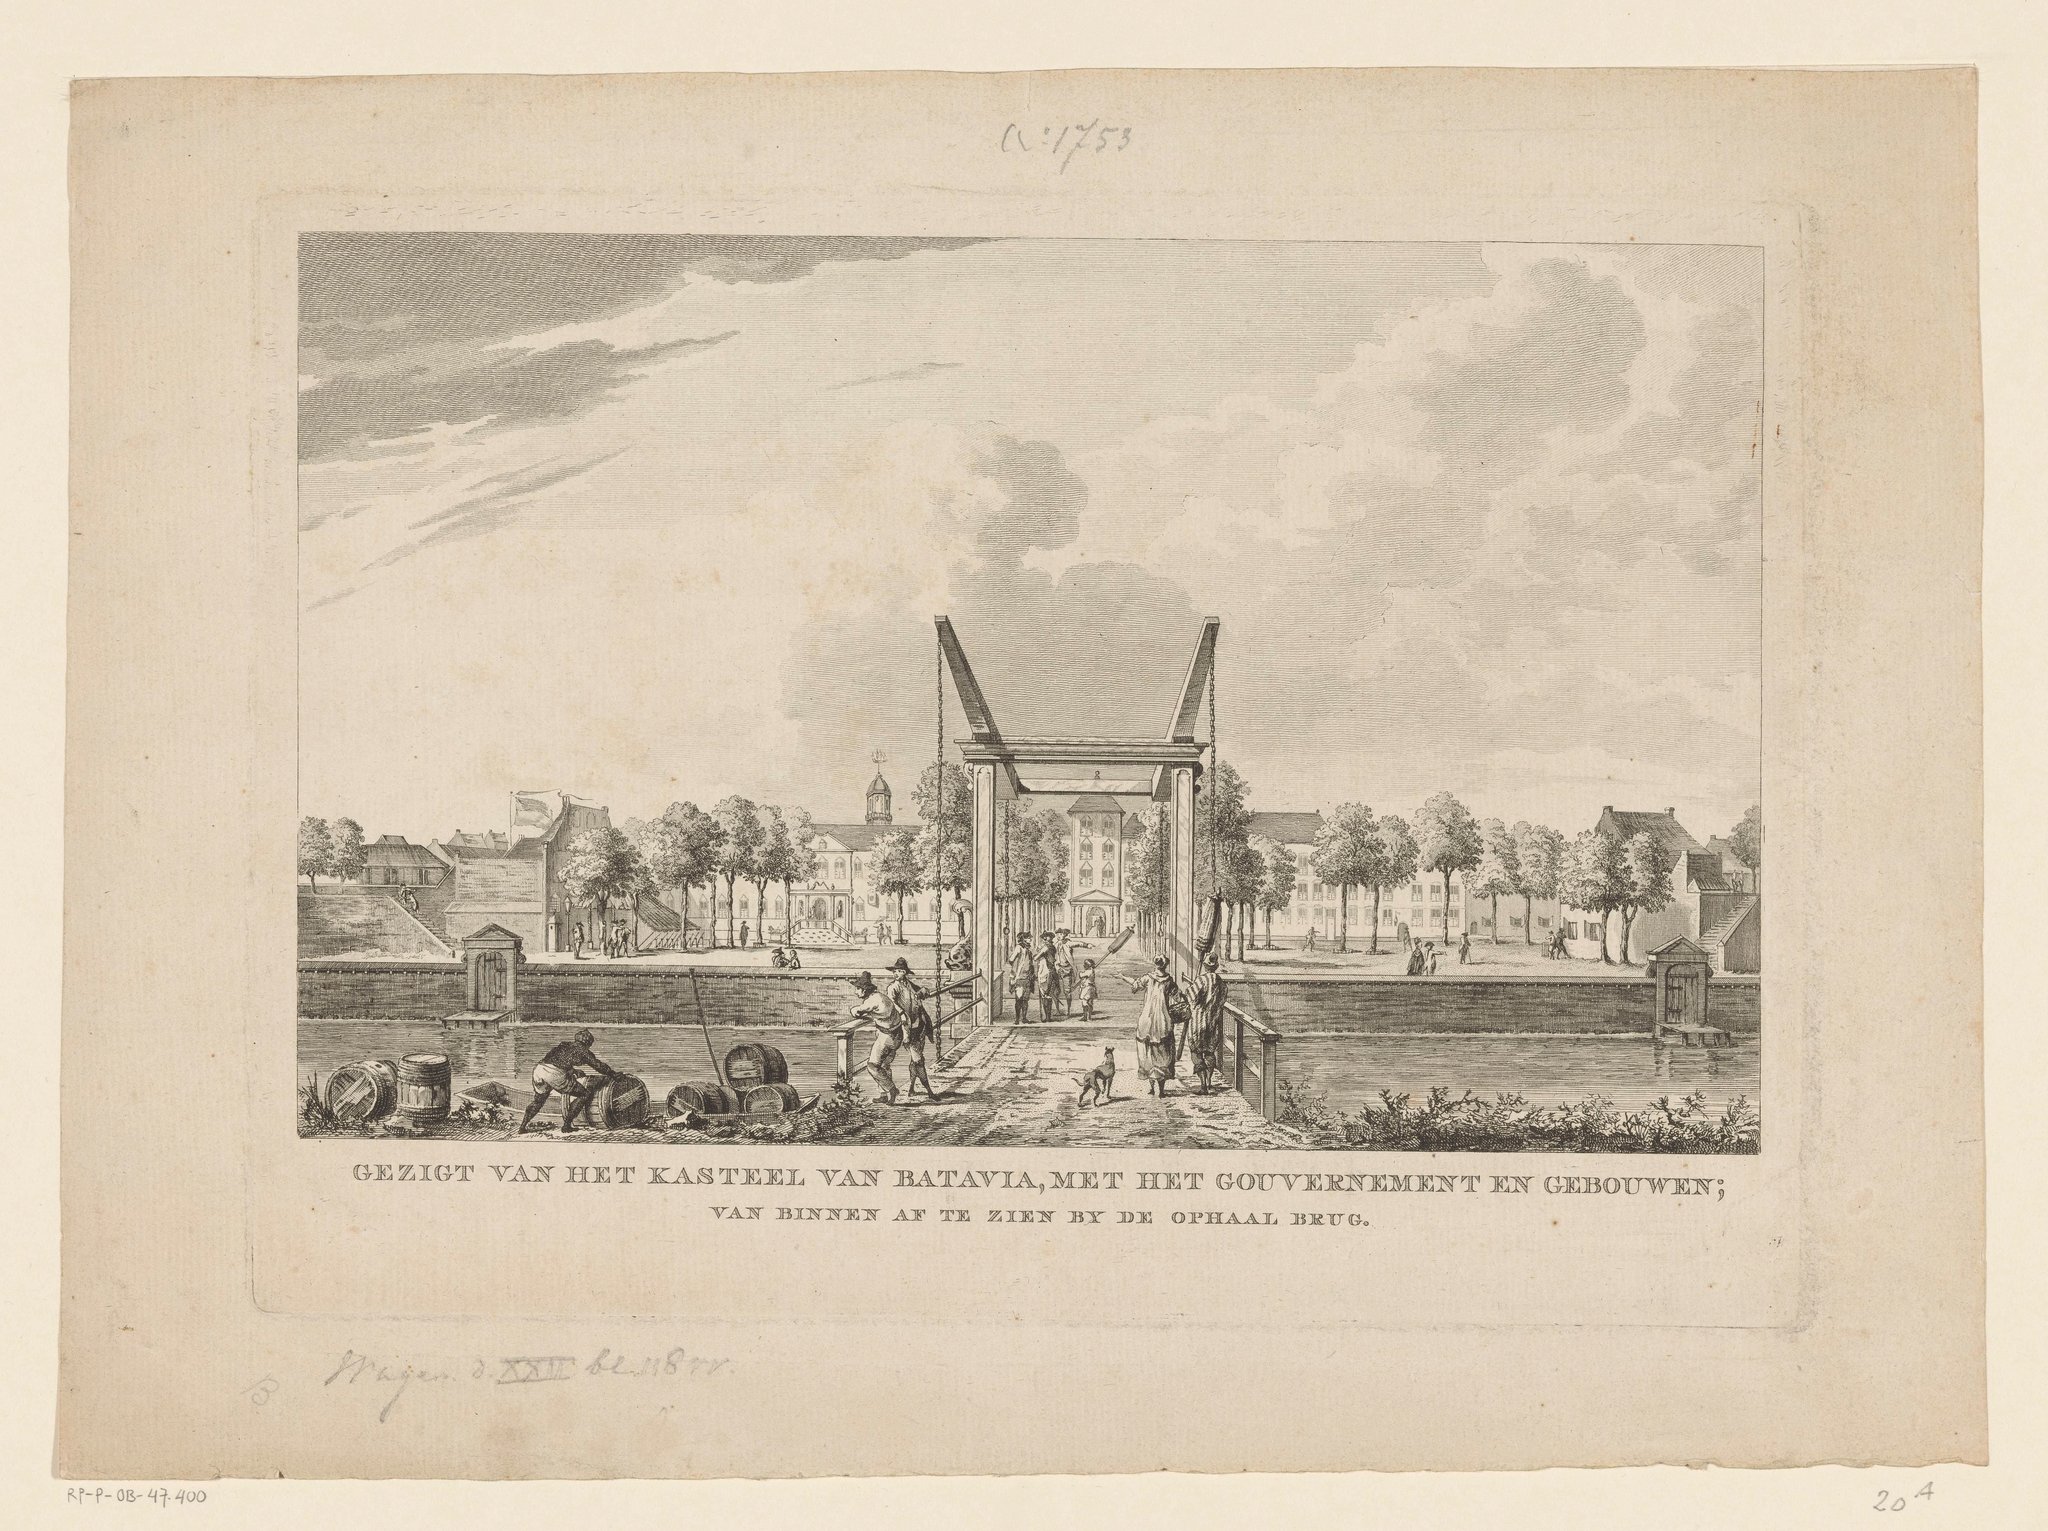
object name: print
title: Gezicht op het kasteel van Batavia vanaf een ophaalbrug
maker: Anonymous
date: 1750-1799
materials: paper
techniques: etching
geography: netherlands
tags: drawbridge ~ fortified city, bascule bridge, batavia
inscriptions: inscription: ‘Ao 1753’